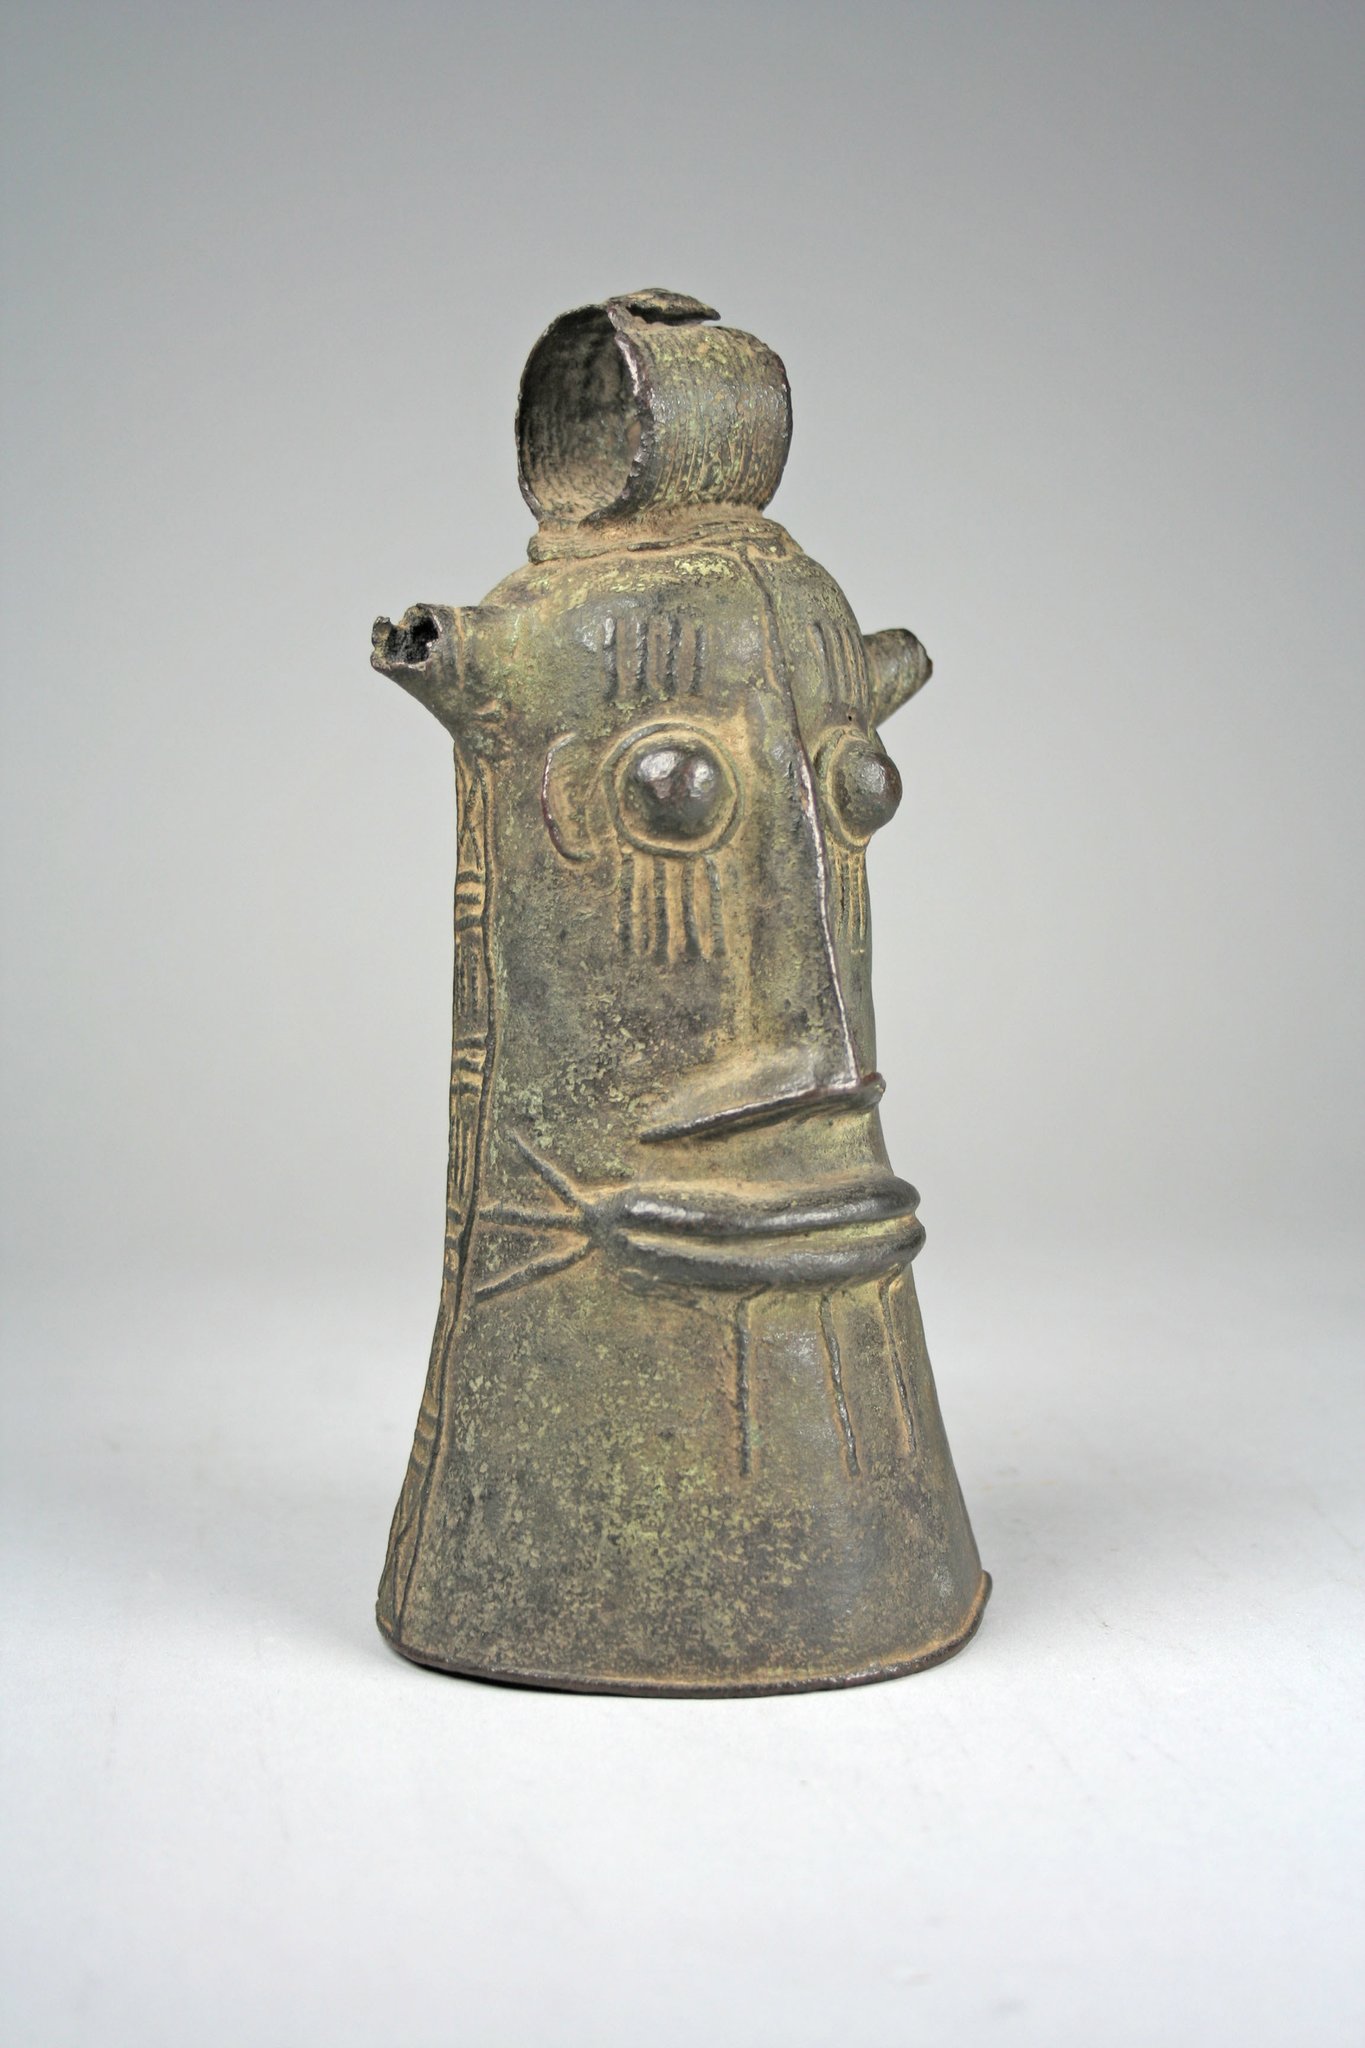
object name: bell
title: Bell head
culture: lower niger bronze industry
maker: lower niger valley caster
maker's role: artist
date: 1401-1900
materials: copper alloy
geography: nigeria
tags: musical instruments,faces